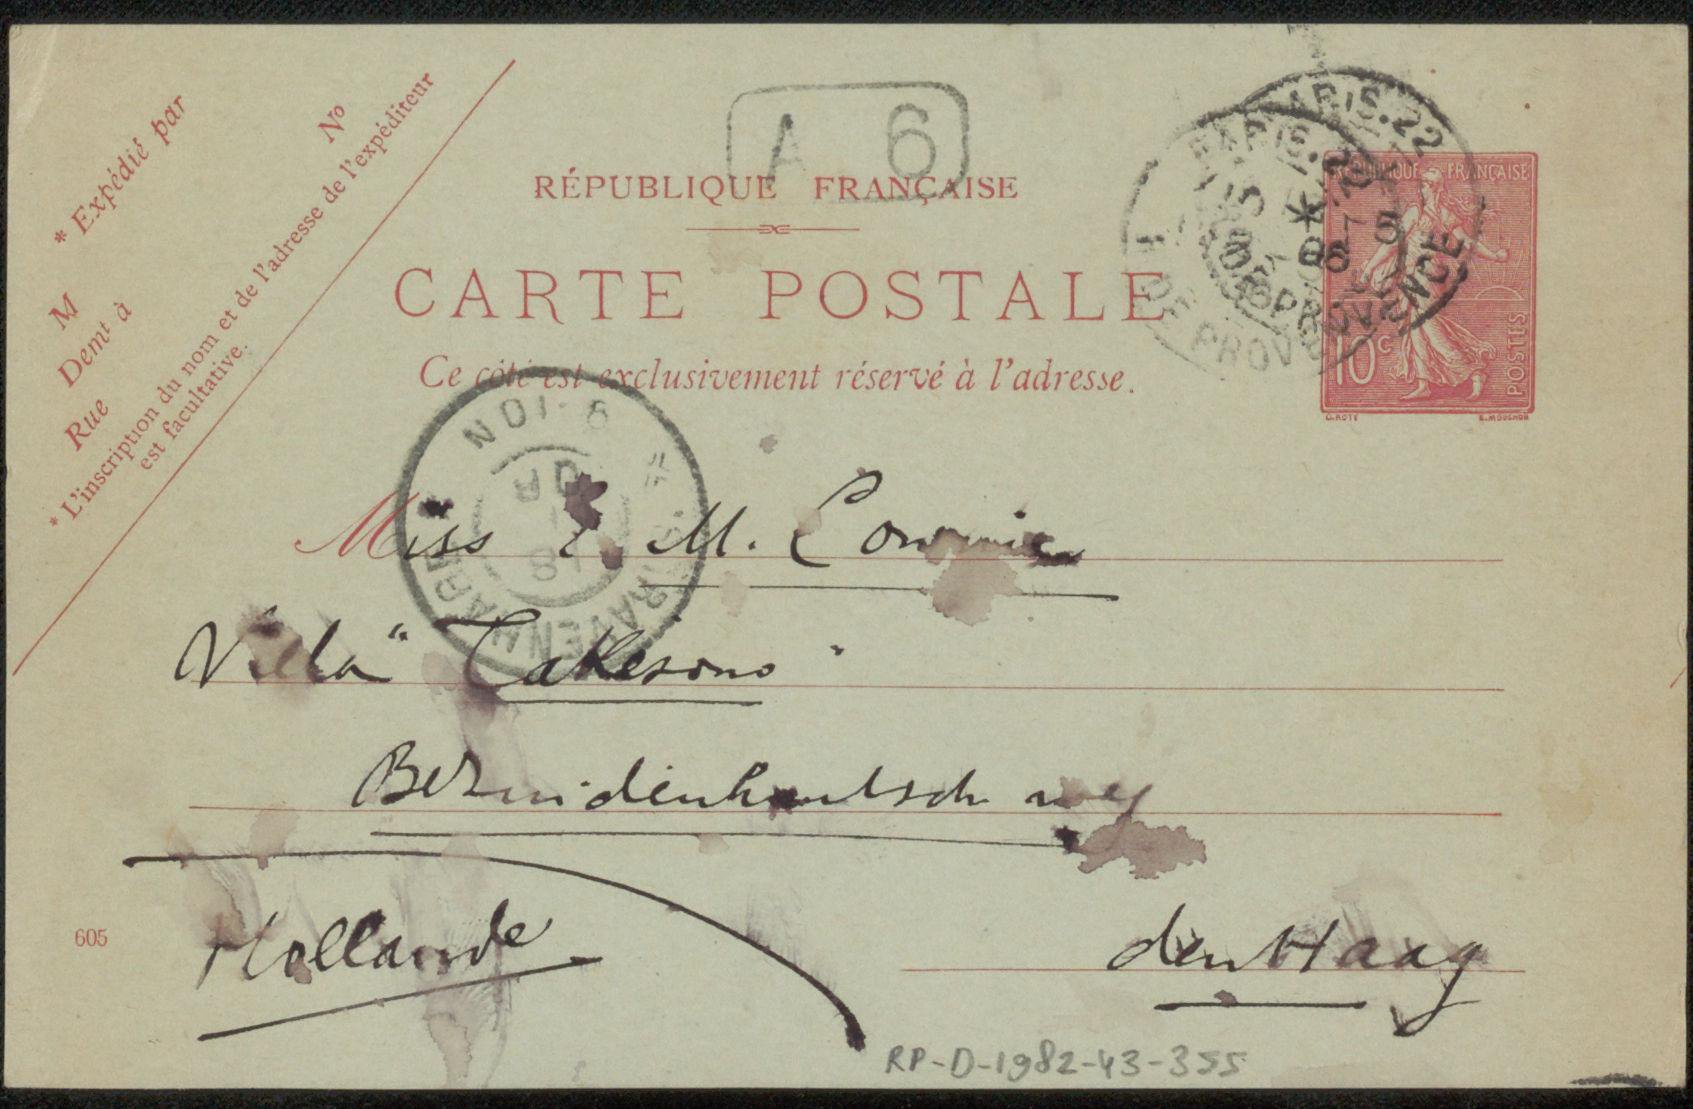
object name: ansichtkaart, prentbriefkaart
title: Prentbriefkaart aan Elsie Maud Cownie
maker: philip zilcken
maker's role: draughtsman, painter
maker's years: 1857-1930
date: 1906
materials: cardboard, ink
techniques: pen, writing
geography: paris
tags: manchester, elsie maud cownie